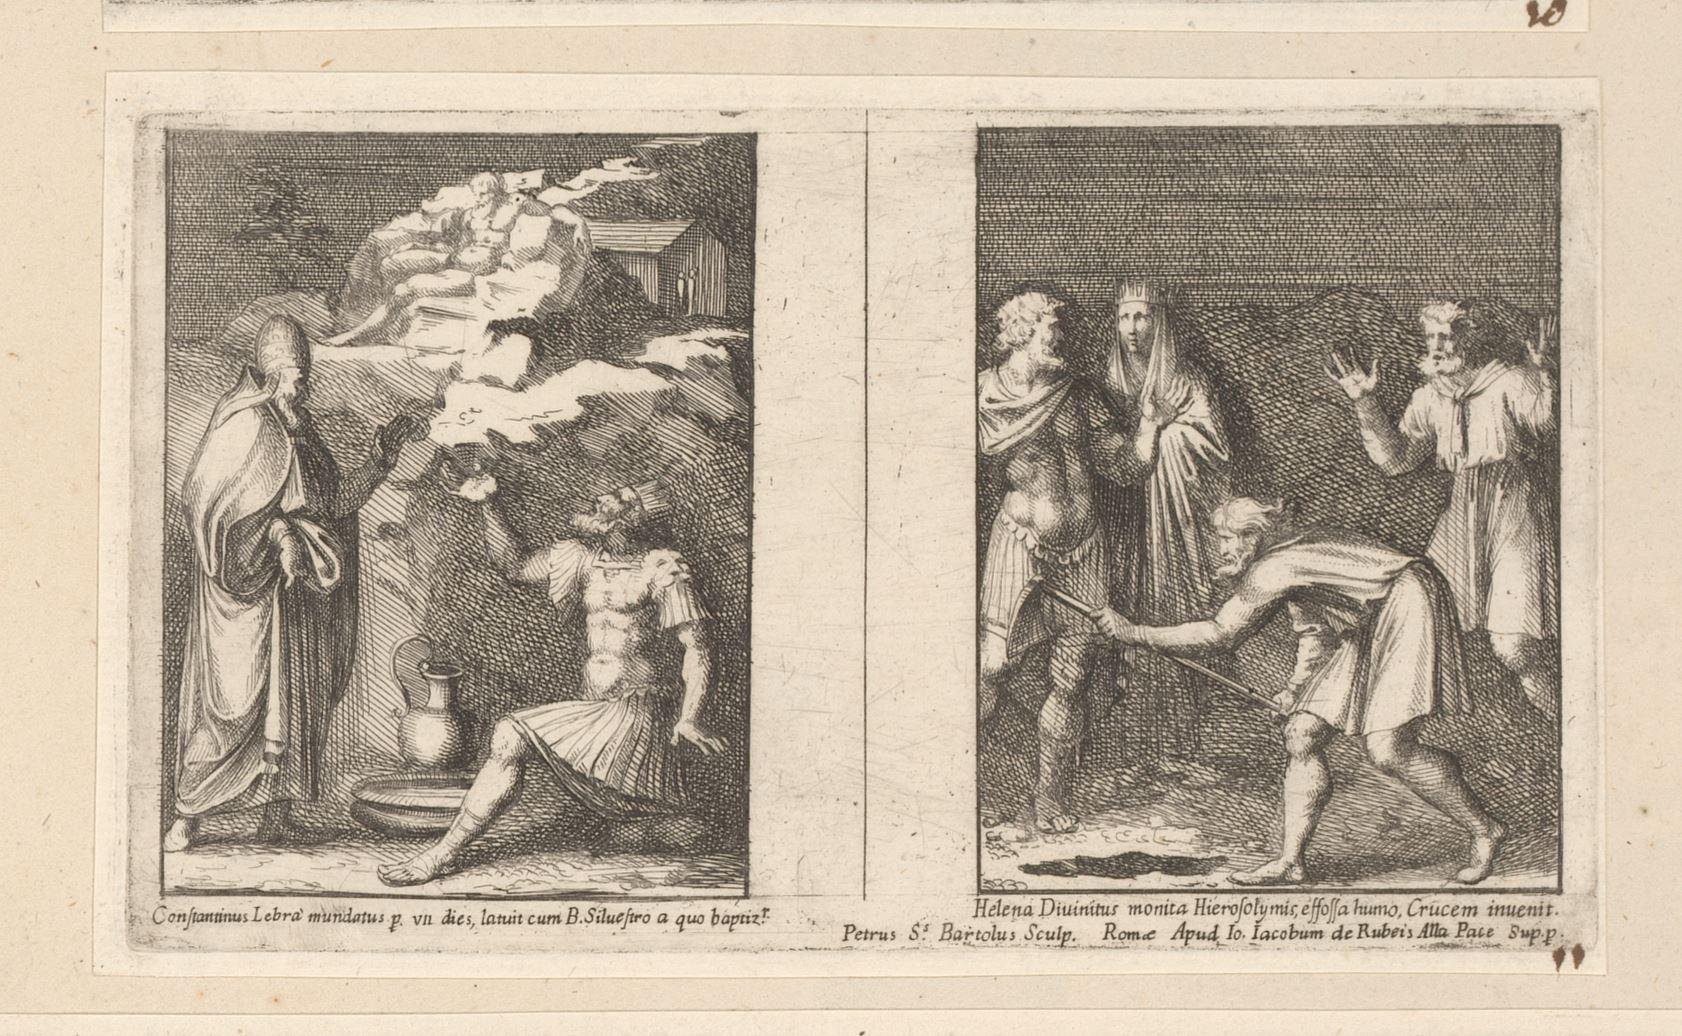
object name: album leaf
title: Paus Silvester geneest Constantijn en de heilige Helena vindt het ware kruis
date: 1637-1691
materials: paper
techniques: engraving, etching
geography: vatican city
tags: rome, miraculous activities and events ~ st. sylvester, the roman emperor constantine the great; possible attributes: crown, sceptre, standard (labarum) with chi-rho monogram or cross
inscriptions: number: ‘46’, number: ‘11’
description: Twee voorstellingen. Titels in de ondermarge. Prent maakt deel uit van een album.